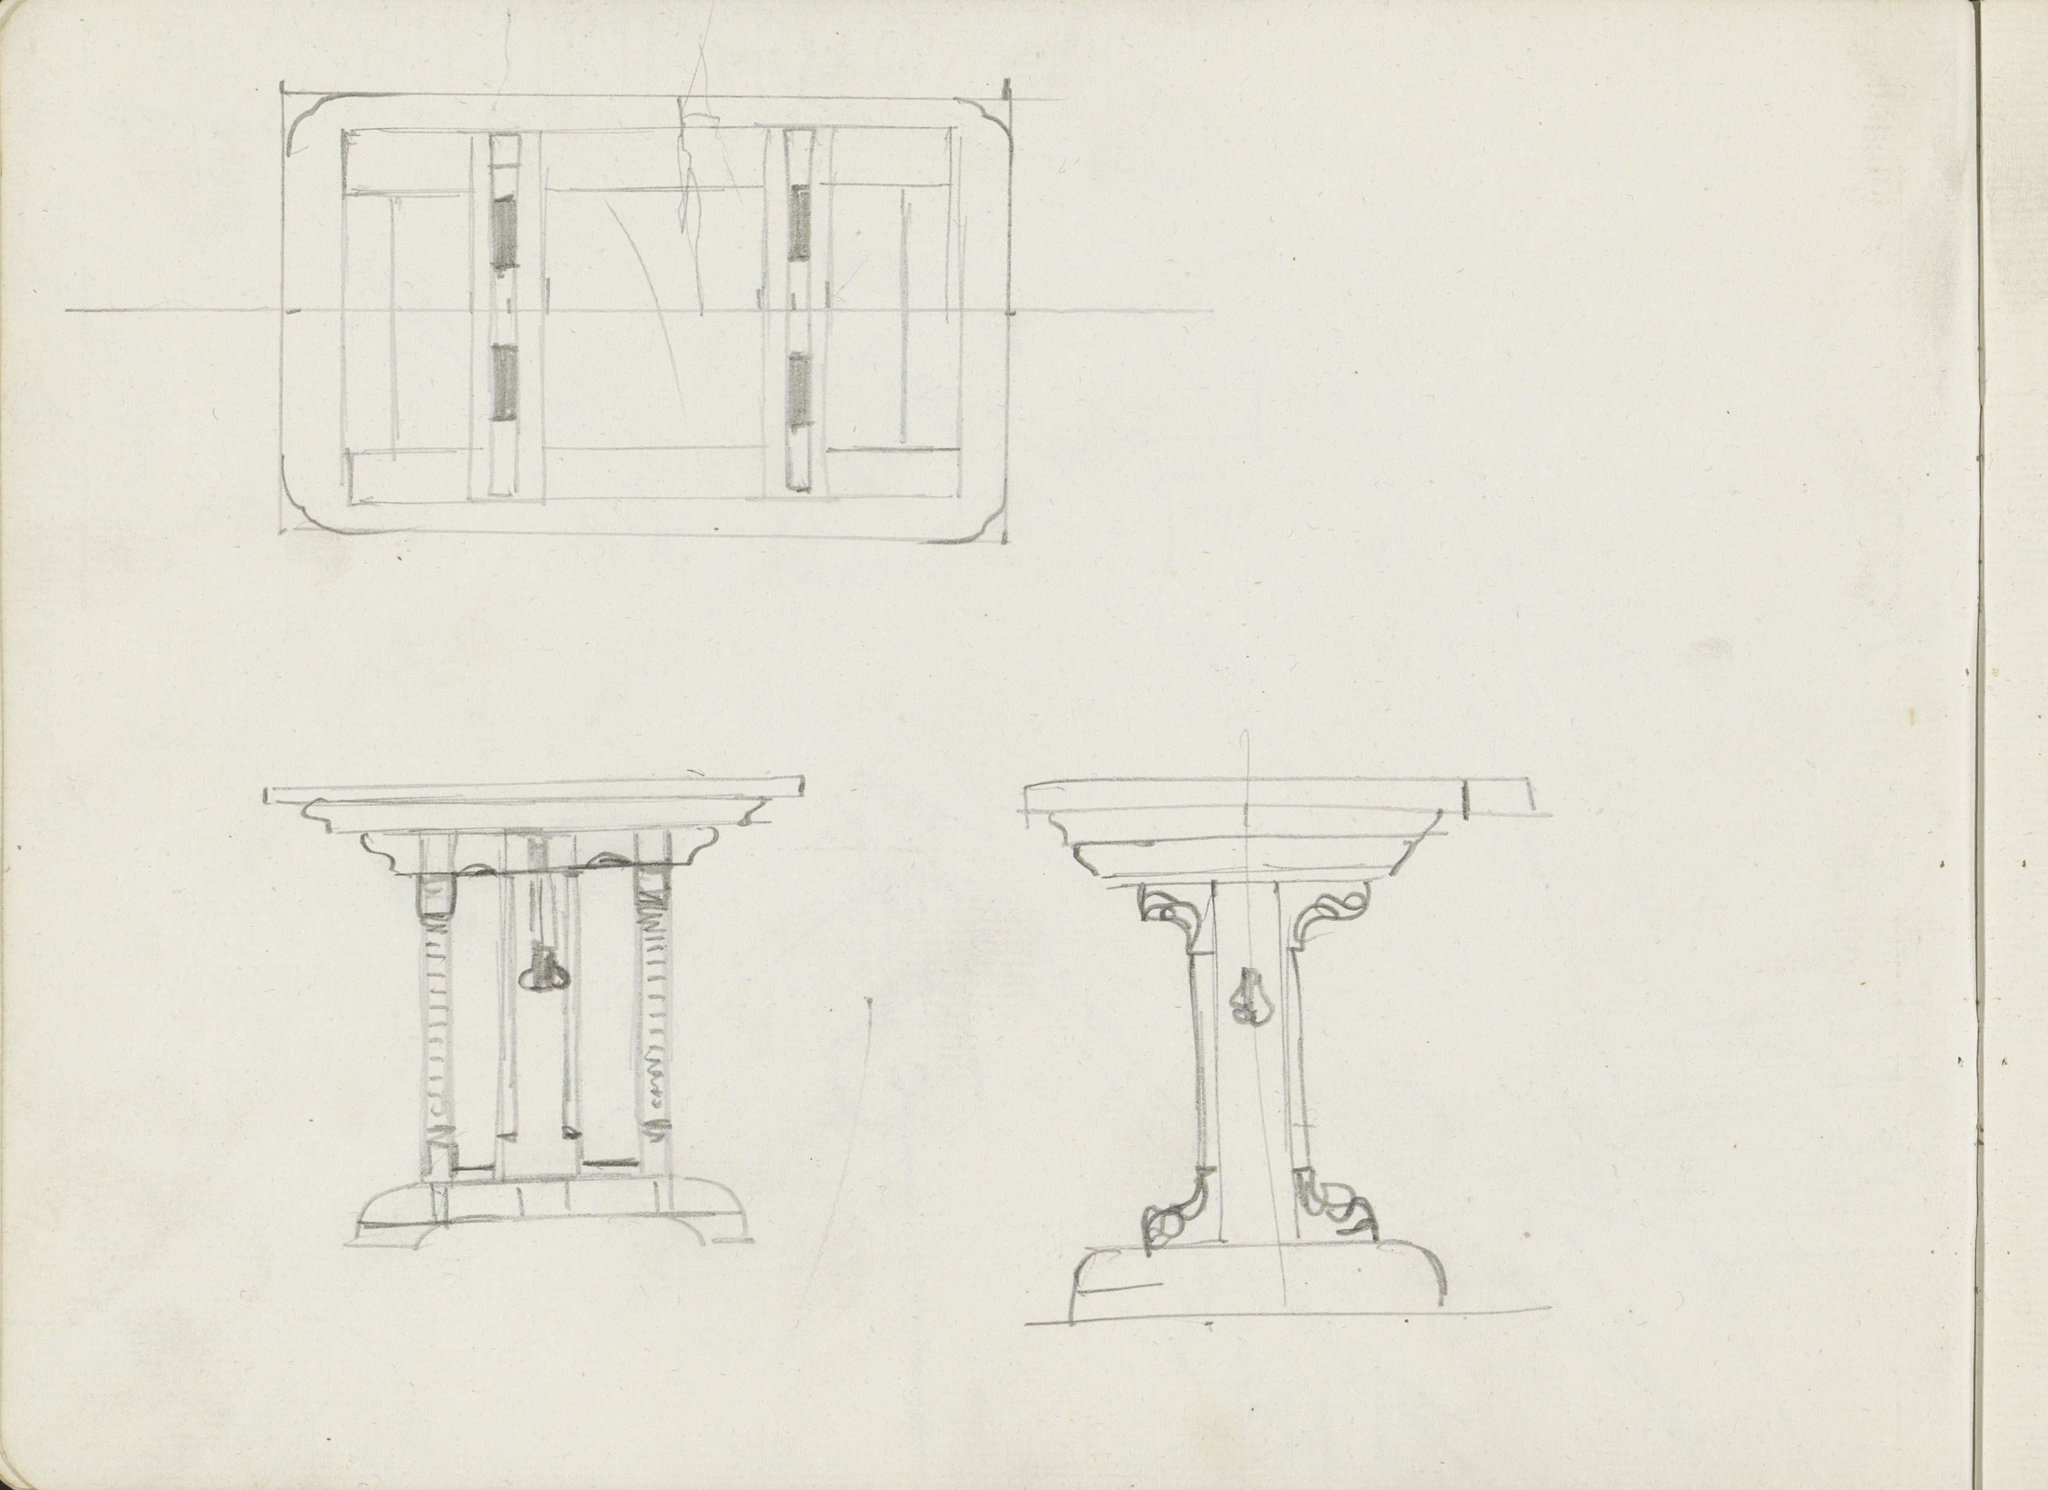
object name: sketchbook leaf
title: Ontwerpen voor het onderstel van een tafel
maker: carel adolph lion cachet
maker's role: draughtsman, print maker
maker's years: 1864-1945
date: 1905-1910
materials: paper, pencil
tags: table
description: Blad 13 verso uit een schetsboek met 27 bladen.